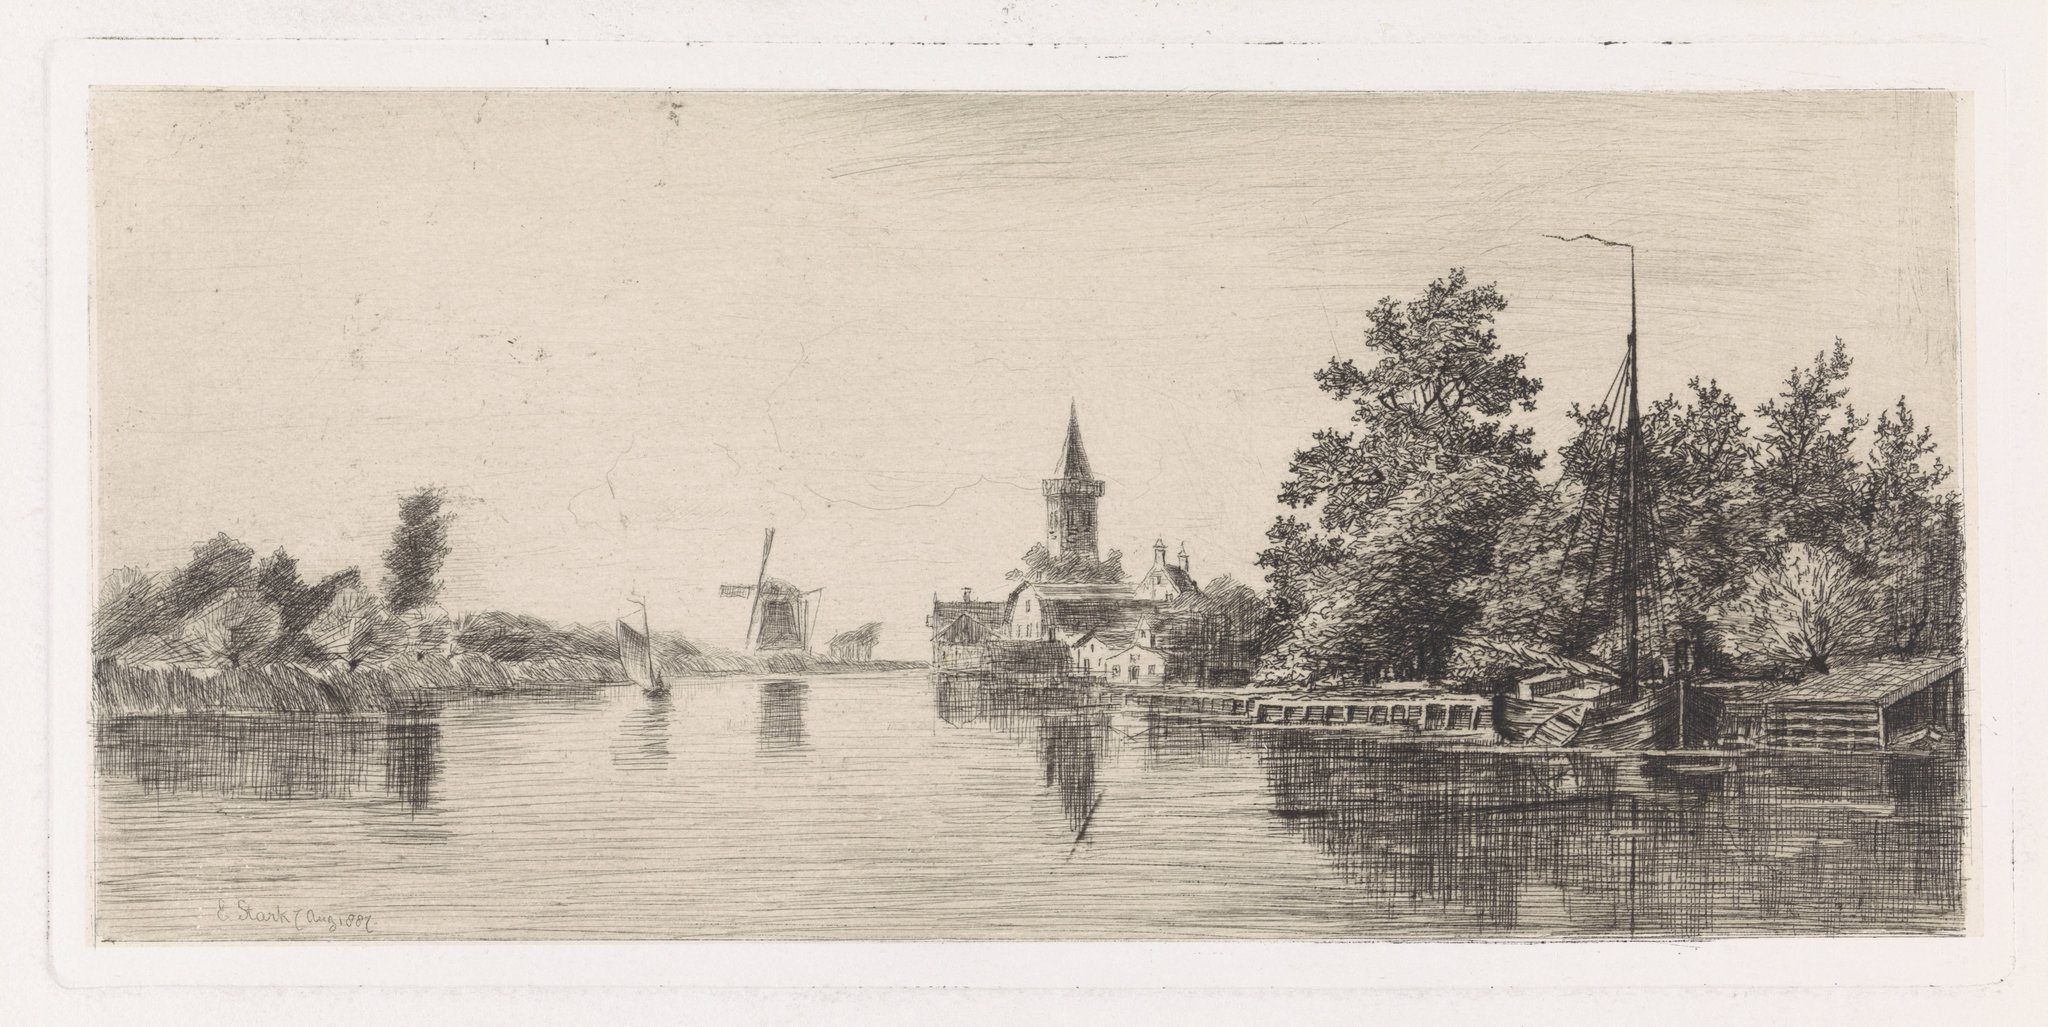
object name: print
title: Gezicht op de Vecht bij Nichtevecht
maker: elias stark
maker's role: draughtsman, print maker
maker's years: 1849-1933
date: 1887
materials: paper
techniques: etching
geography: nieuwer-amstel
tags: river, windmill in landscape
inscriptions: collector's mark: Lugt 2228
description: Gezicht op de rivier de Vecht met rechts op de oever het dorp Nichtevecht. Rechts op de voorgrond ligt een schip afgemeerd. Op de achtergrond een molen.